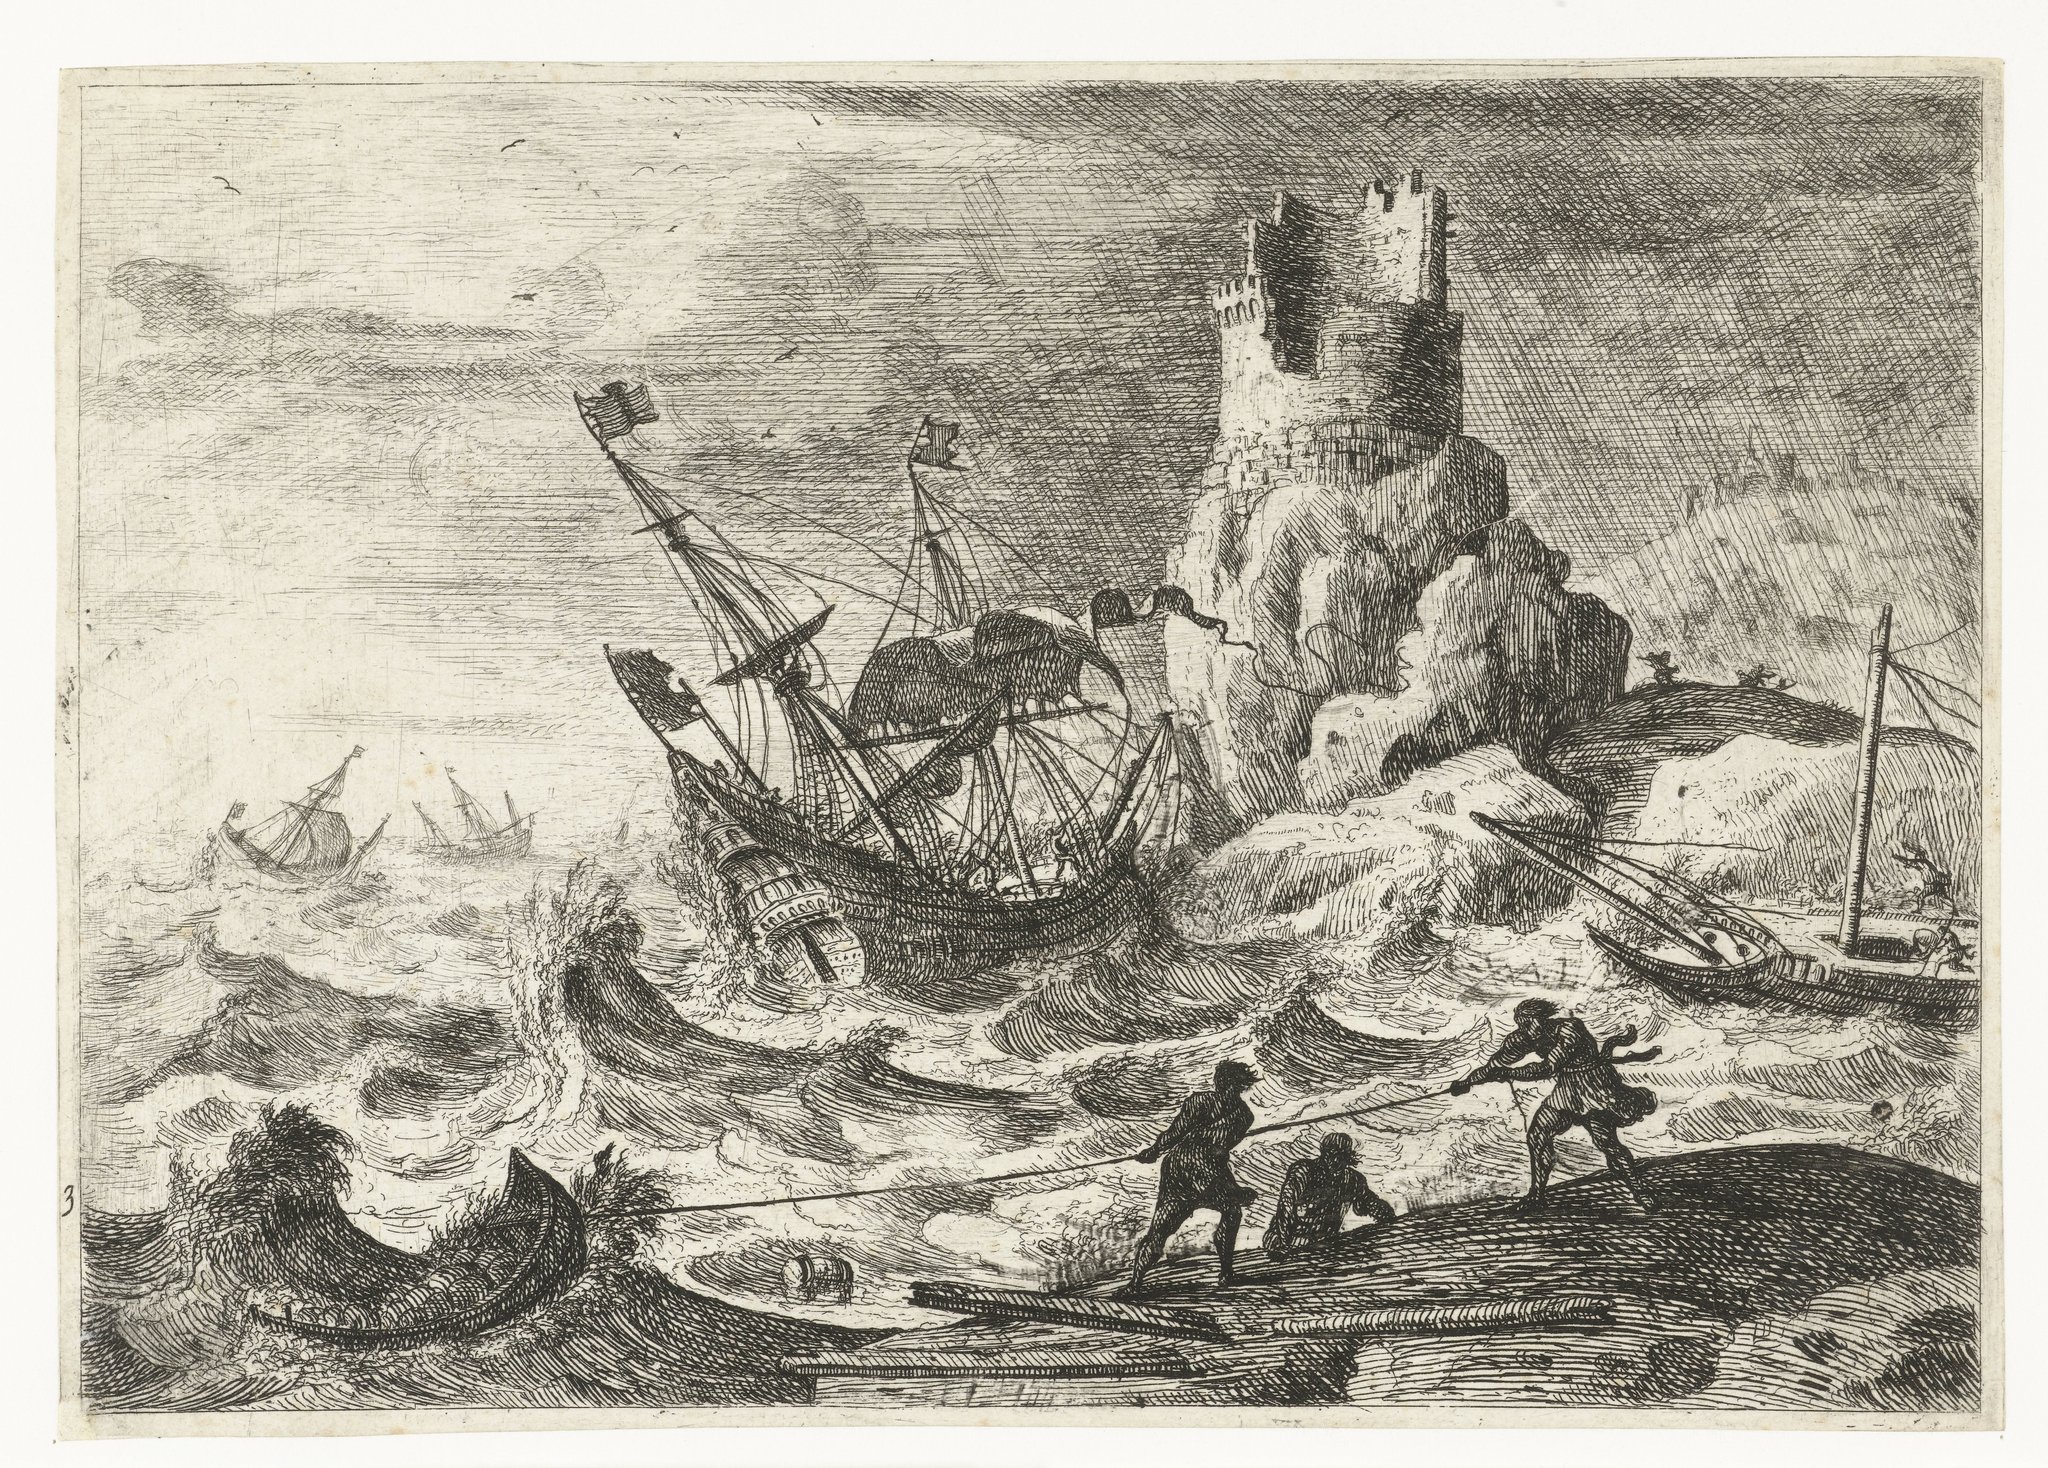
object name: print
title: Le Naufrage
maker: claude lorrain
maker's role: draughtsman, print maker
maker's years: 1604-1682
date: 1638-1641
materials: paper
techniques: etching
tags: shipwreck, storm at sea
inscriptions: collector's mark: Lugt 240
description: Drie schepen lijden schipbreuk op een stormachtige zee vlakbij de kust. Drie mannen op de romp van een omgeslagen schip, trekken met een touw een sloep naar zich toe.